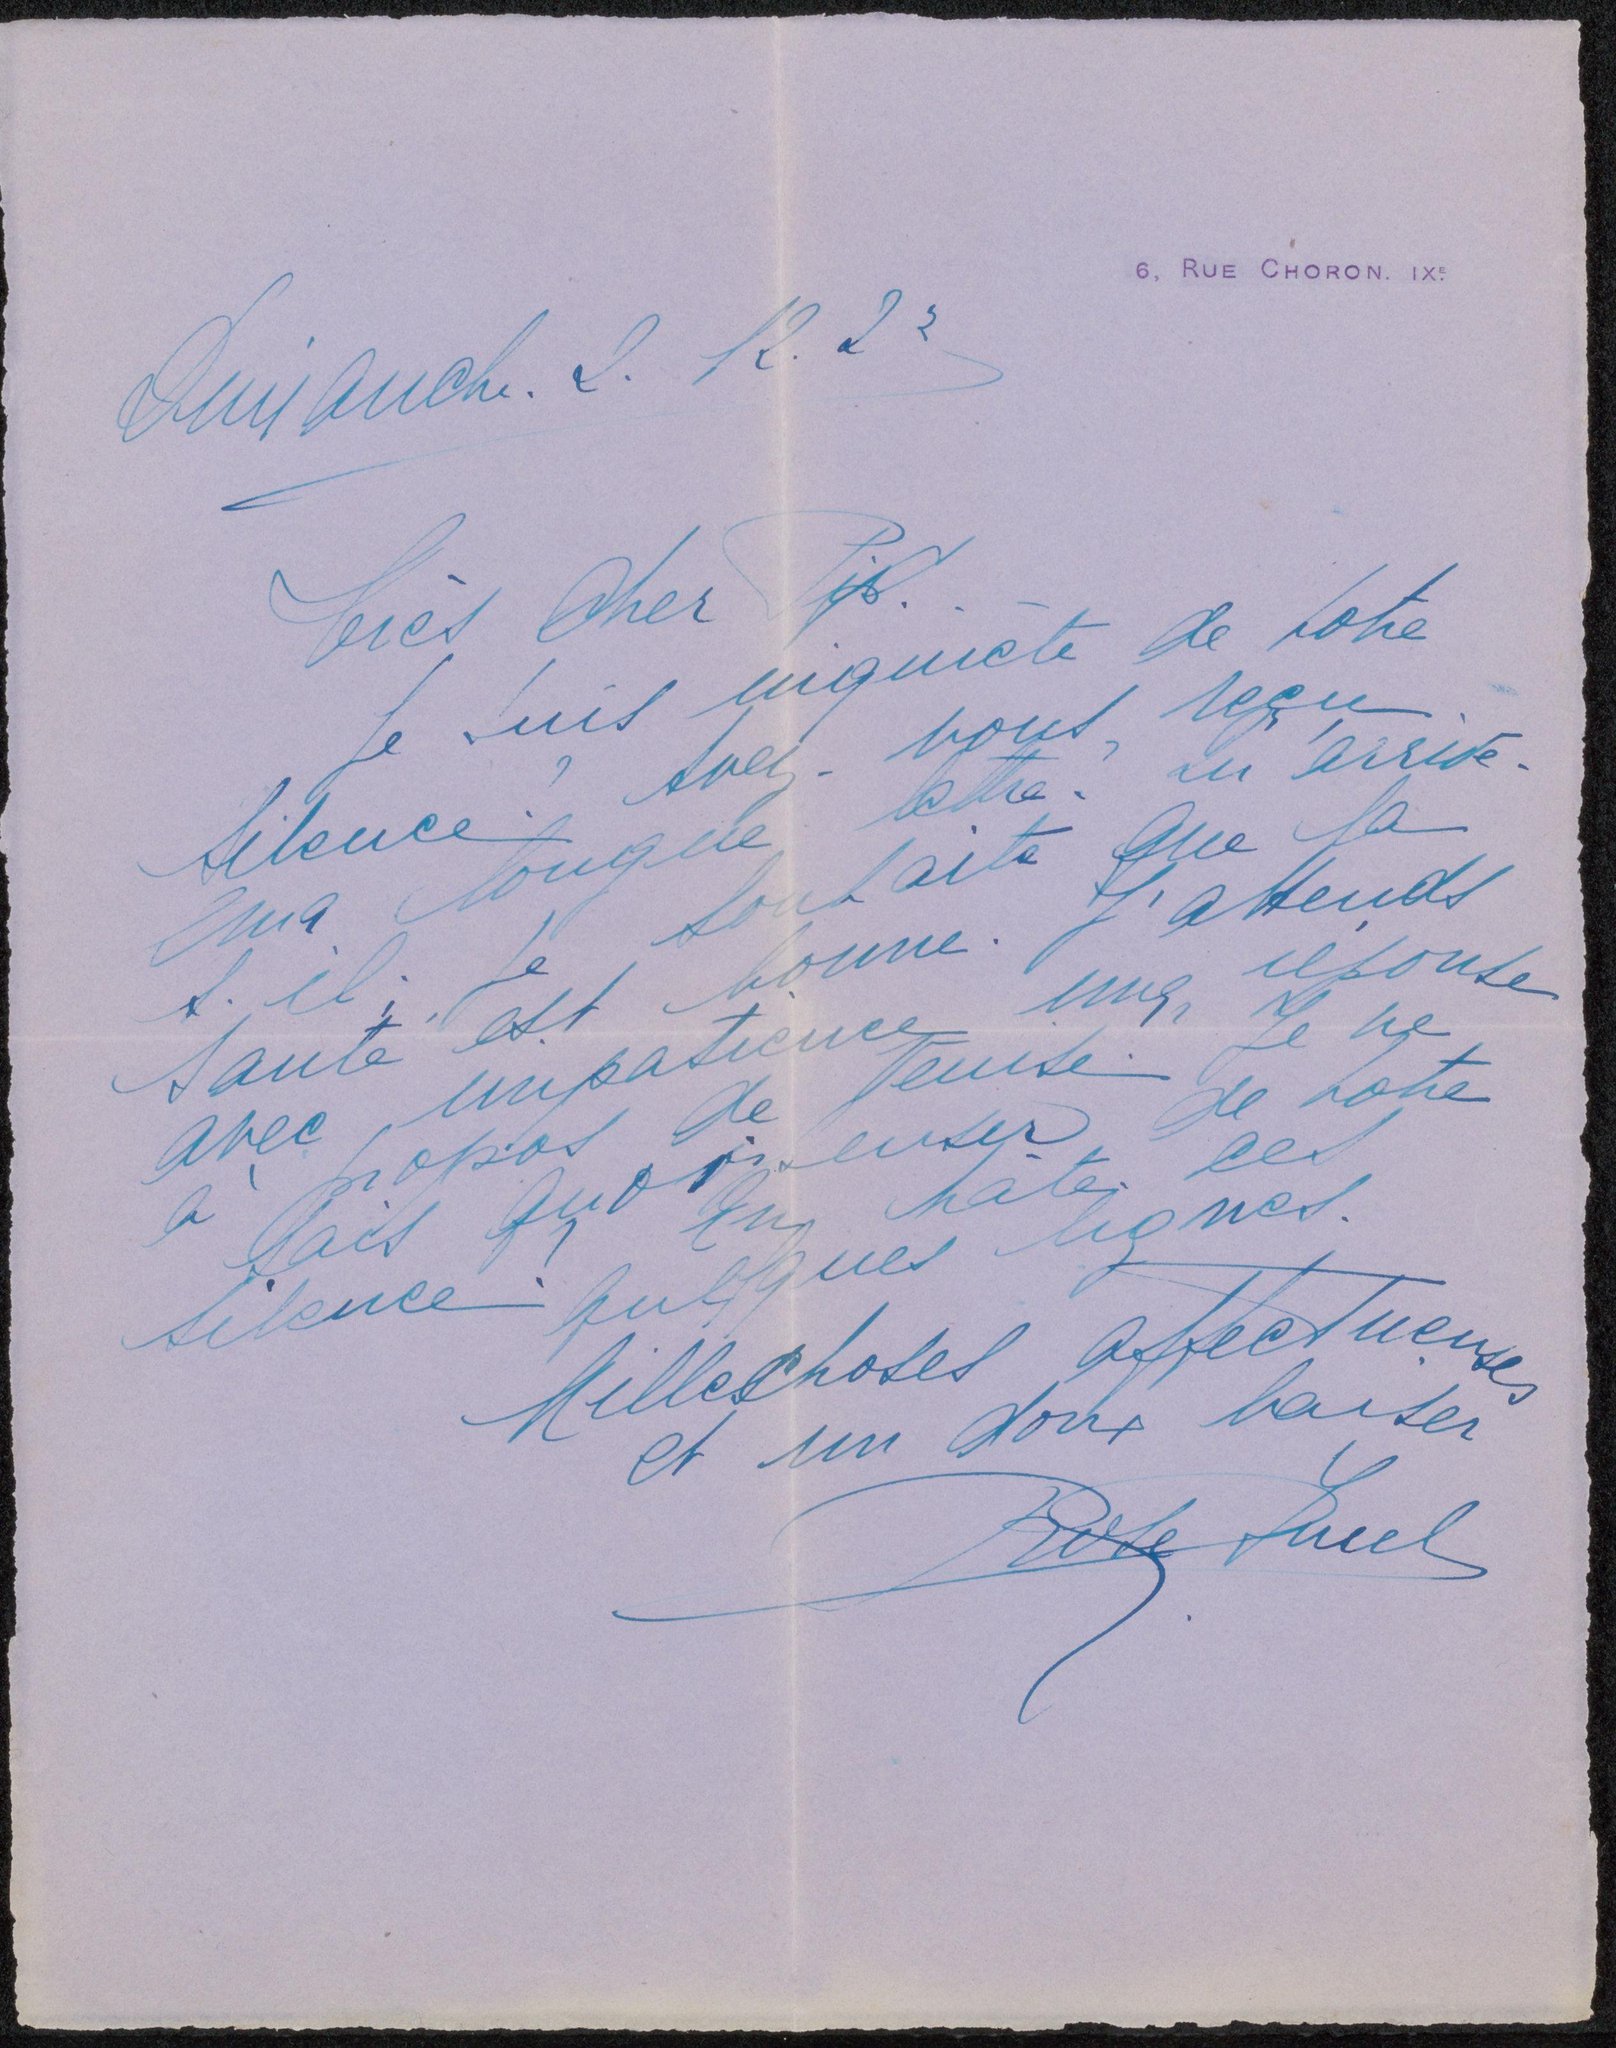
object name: letter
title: Brief aan Philip Zilcken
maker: rose imel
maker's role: draughtsman, painter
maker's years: 1901-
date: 1923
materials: ink, paper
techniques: pen, printing, writing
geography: paris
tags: painter, draughtsman, philip zilcken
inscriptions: collector's mark: ‘RPK’